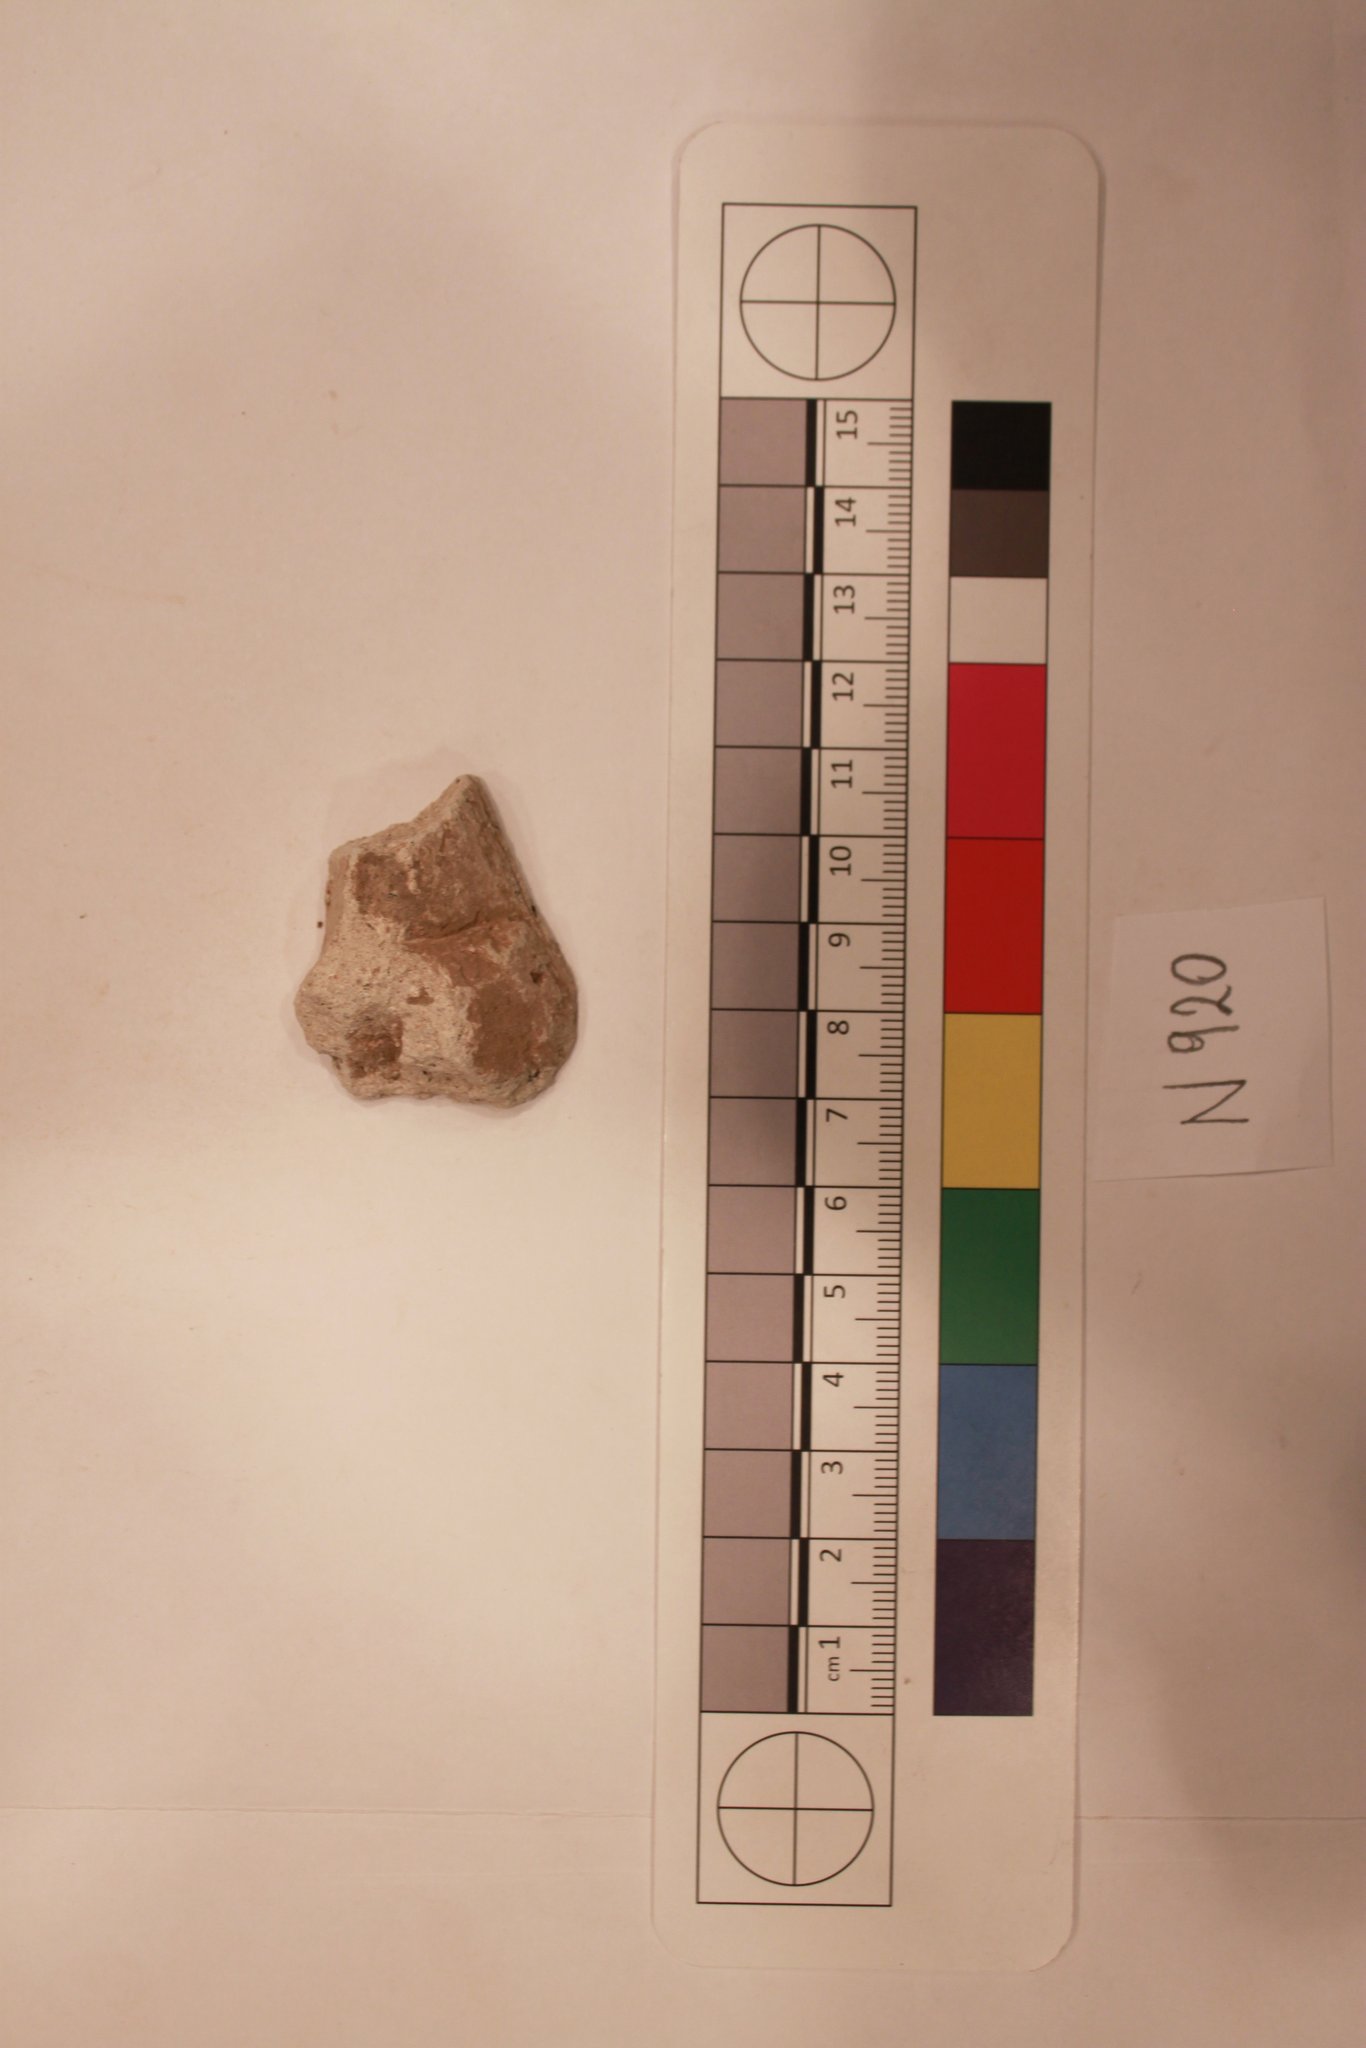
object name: fragment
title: Stucco Fragment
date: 701-1200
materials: plaster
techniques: carving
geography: iran